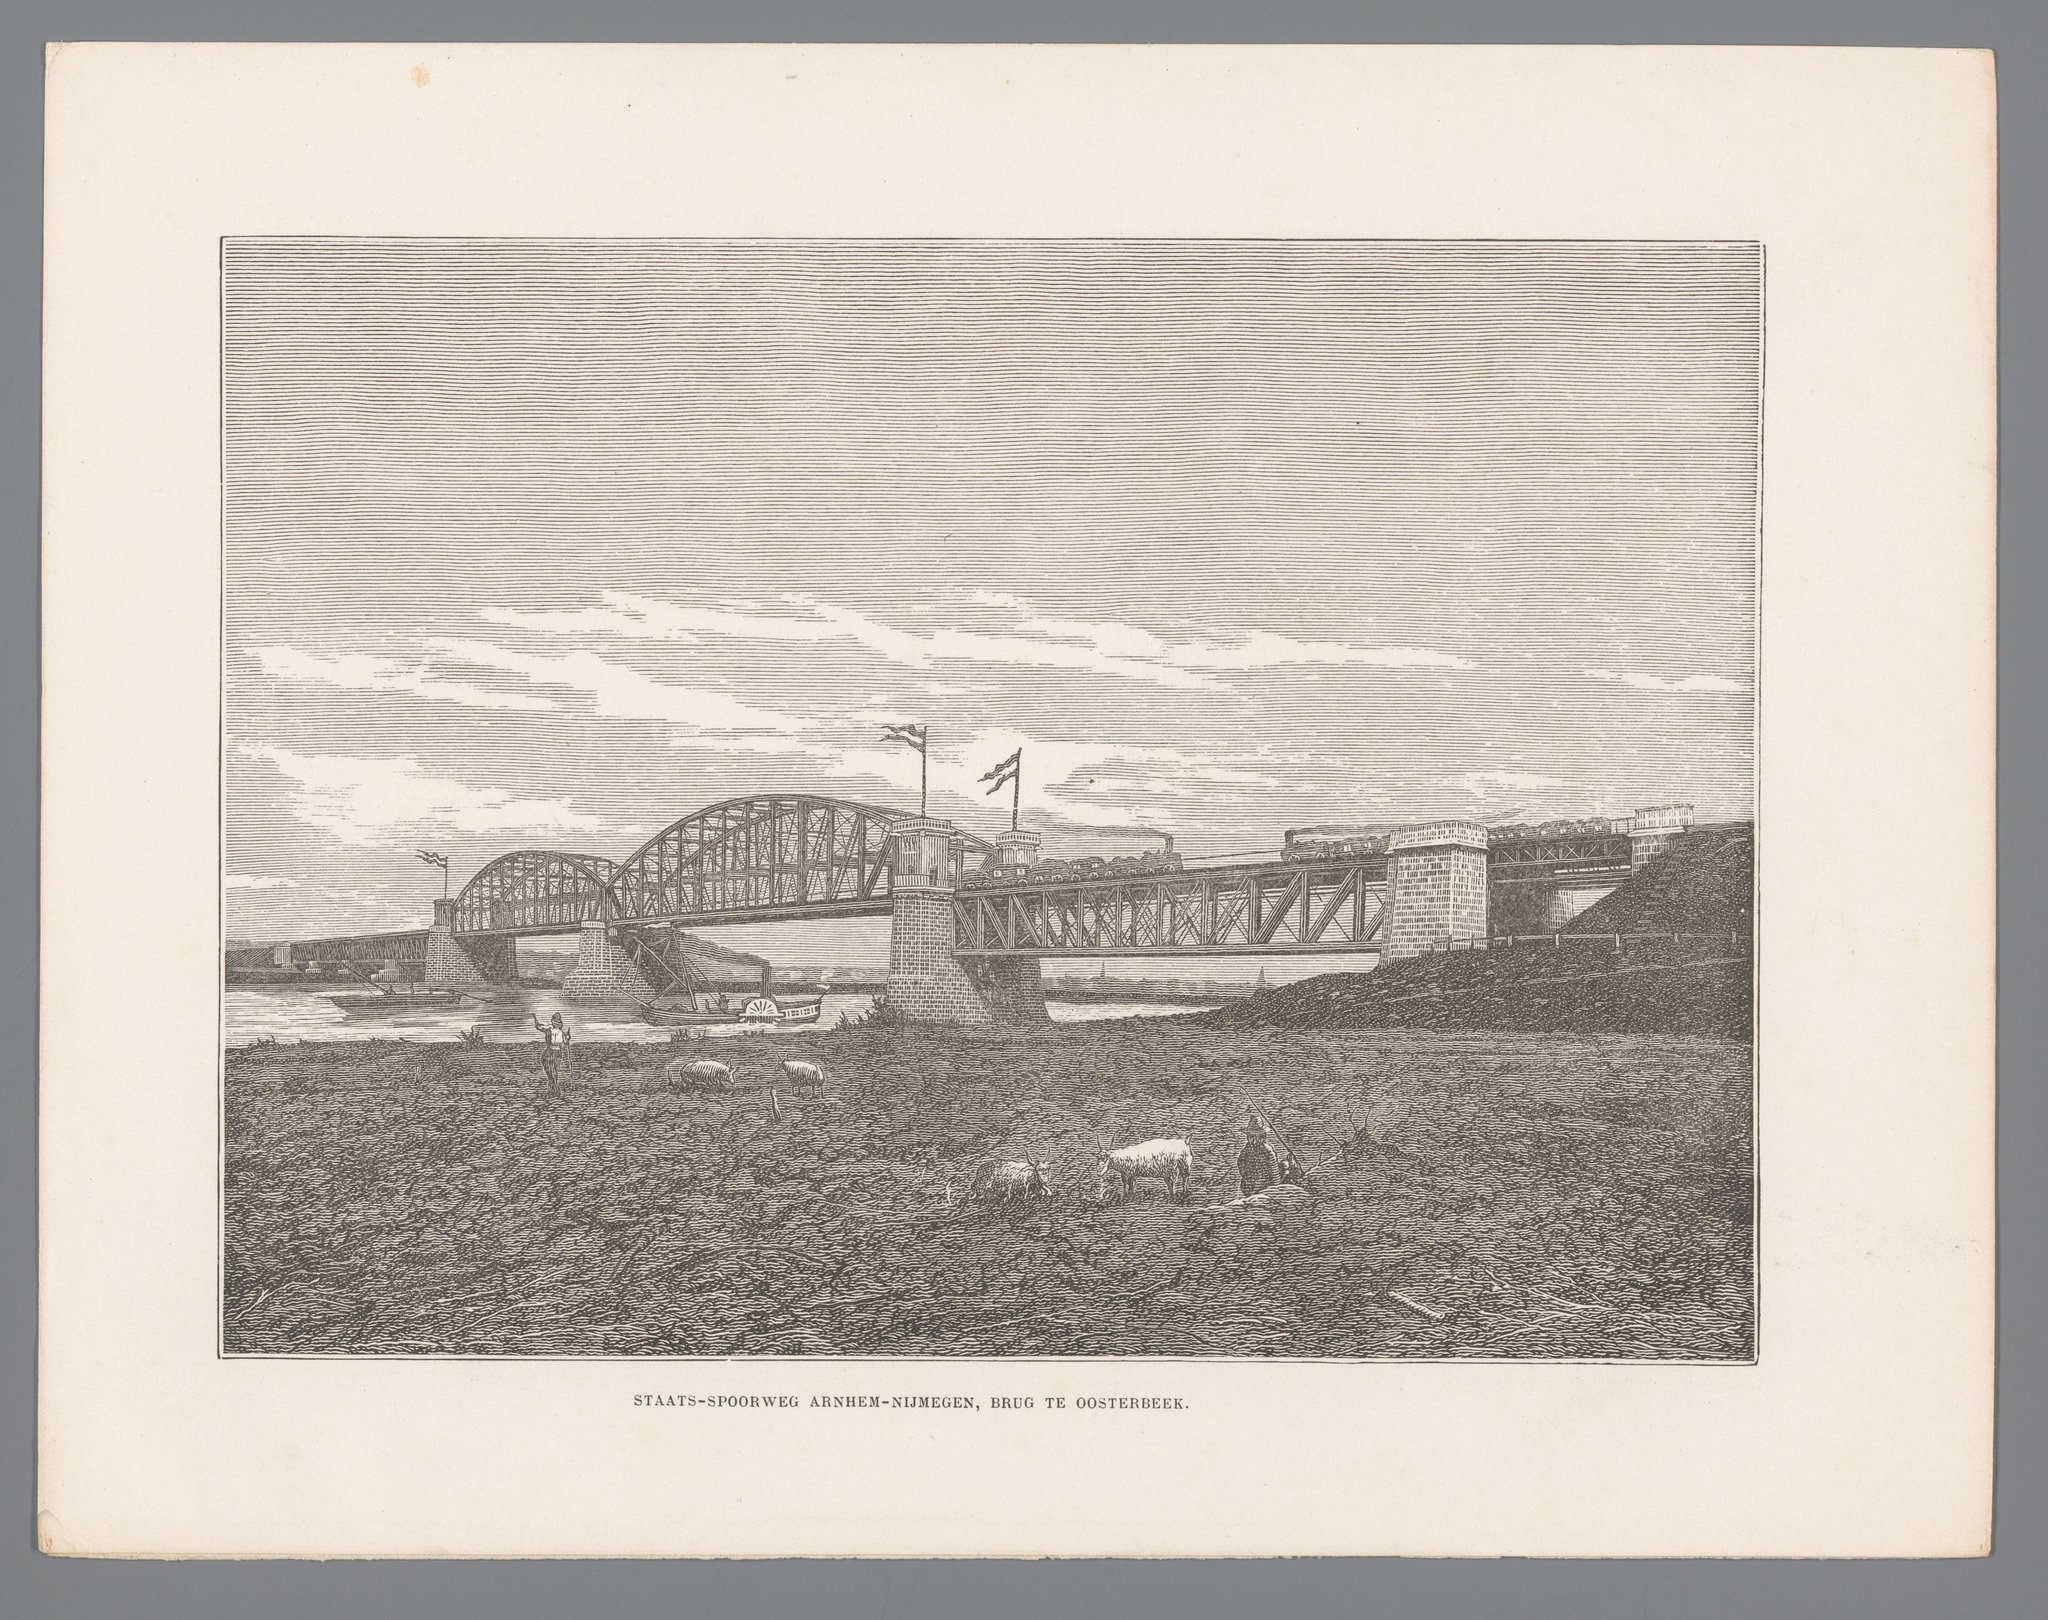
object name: photomechanical print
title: Reproductie van een tekening of prent met een gezicht op de spoorbrug bij Oosterbeek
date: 1880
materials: paper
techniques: photolithography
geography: haarlem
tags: bridge with structure, i.e. cover or buildings, railway, train, bridge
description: Prent uit: Nederlandsche kunstbode, beeldende kunst, oudheidkunde, kunstnijverheid, vol. 2, 1880.